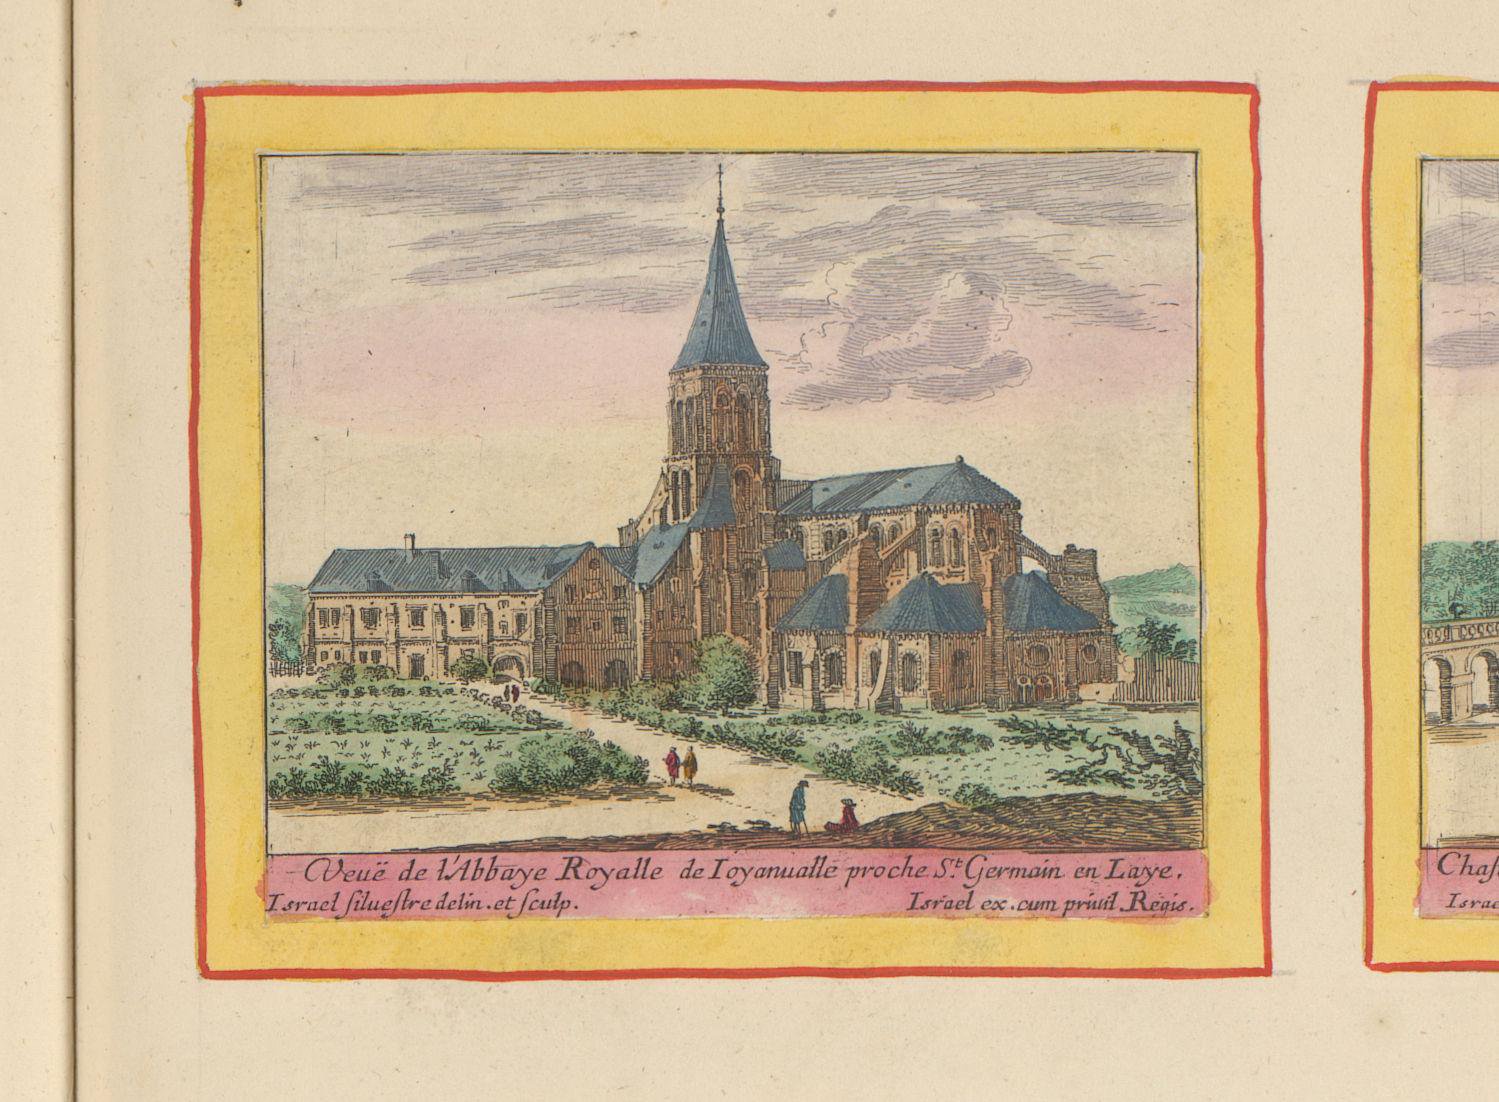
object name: print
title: Gezicht op de koninklijke abdij in de buurt van Saint-Germain-en-Laye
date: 1631-1661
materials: paper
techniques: etching, hand coloring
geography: paris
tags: abbey, monastery, convent ~ roman catholic church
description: Gezicht op de koninklijke abdij in de buurt van Saint-Germain-en-Laye. Prent maakt deel uit van een album.